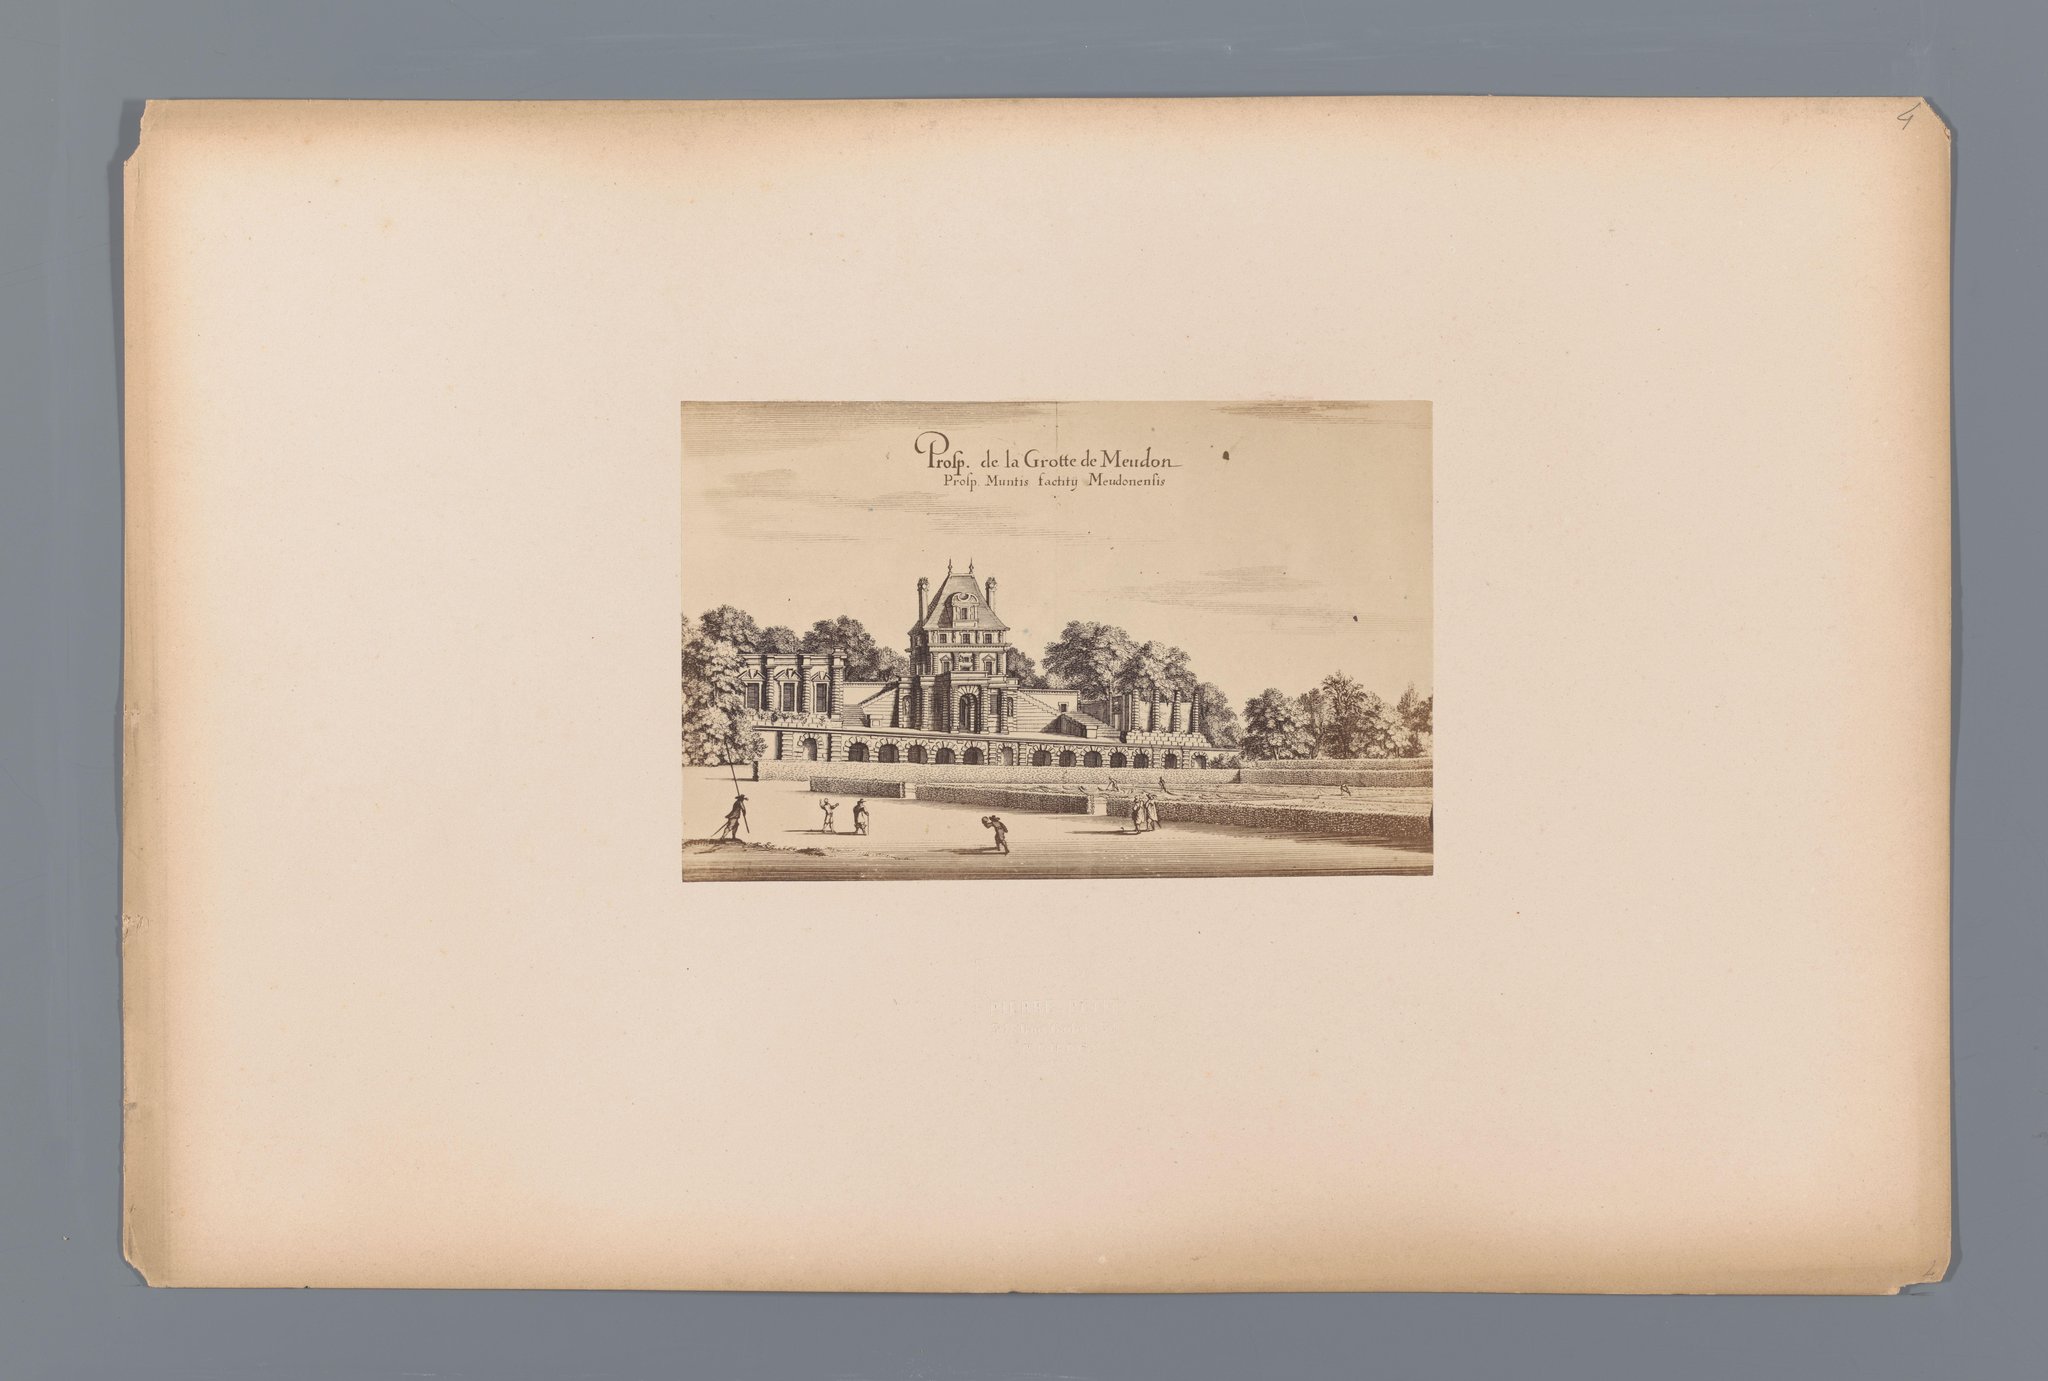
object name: reproduction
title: Fotoreproductie van een ontwerp van de grot bij het kasteel van Meudon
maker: pierre petit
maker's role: fotograaf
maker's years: 1832-1909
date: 1860-1865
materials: photographic support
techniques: albumen print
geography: paris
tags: castle, cave, grotto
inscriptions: number: ‘4’, check stamp: ‘PHOTOGRAPHIE des DEUX MONDES/ PIERRE PETIT/ 31, Rue Cadet, 31/ PARIS’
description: Deze foto maakt deel uit van een omslag met 38 foto's en 17 tekstbladen.